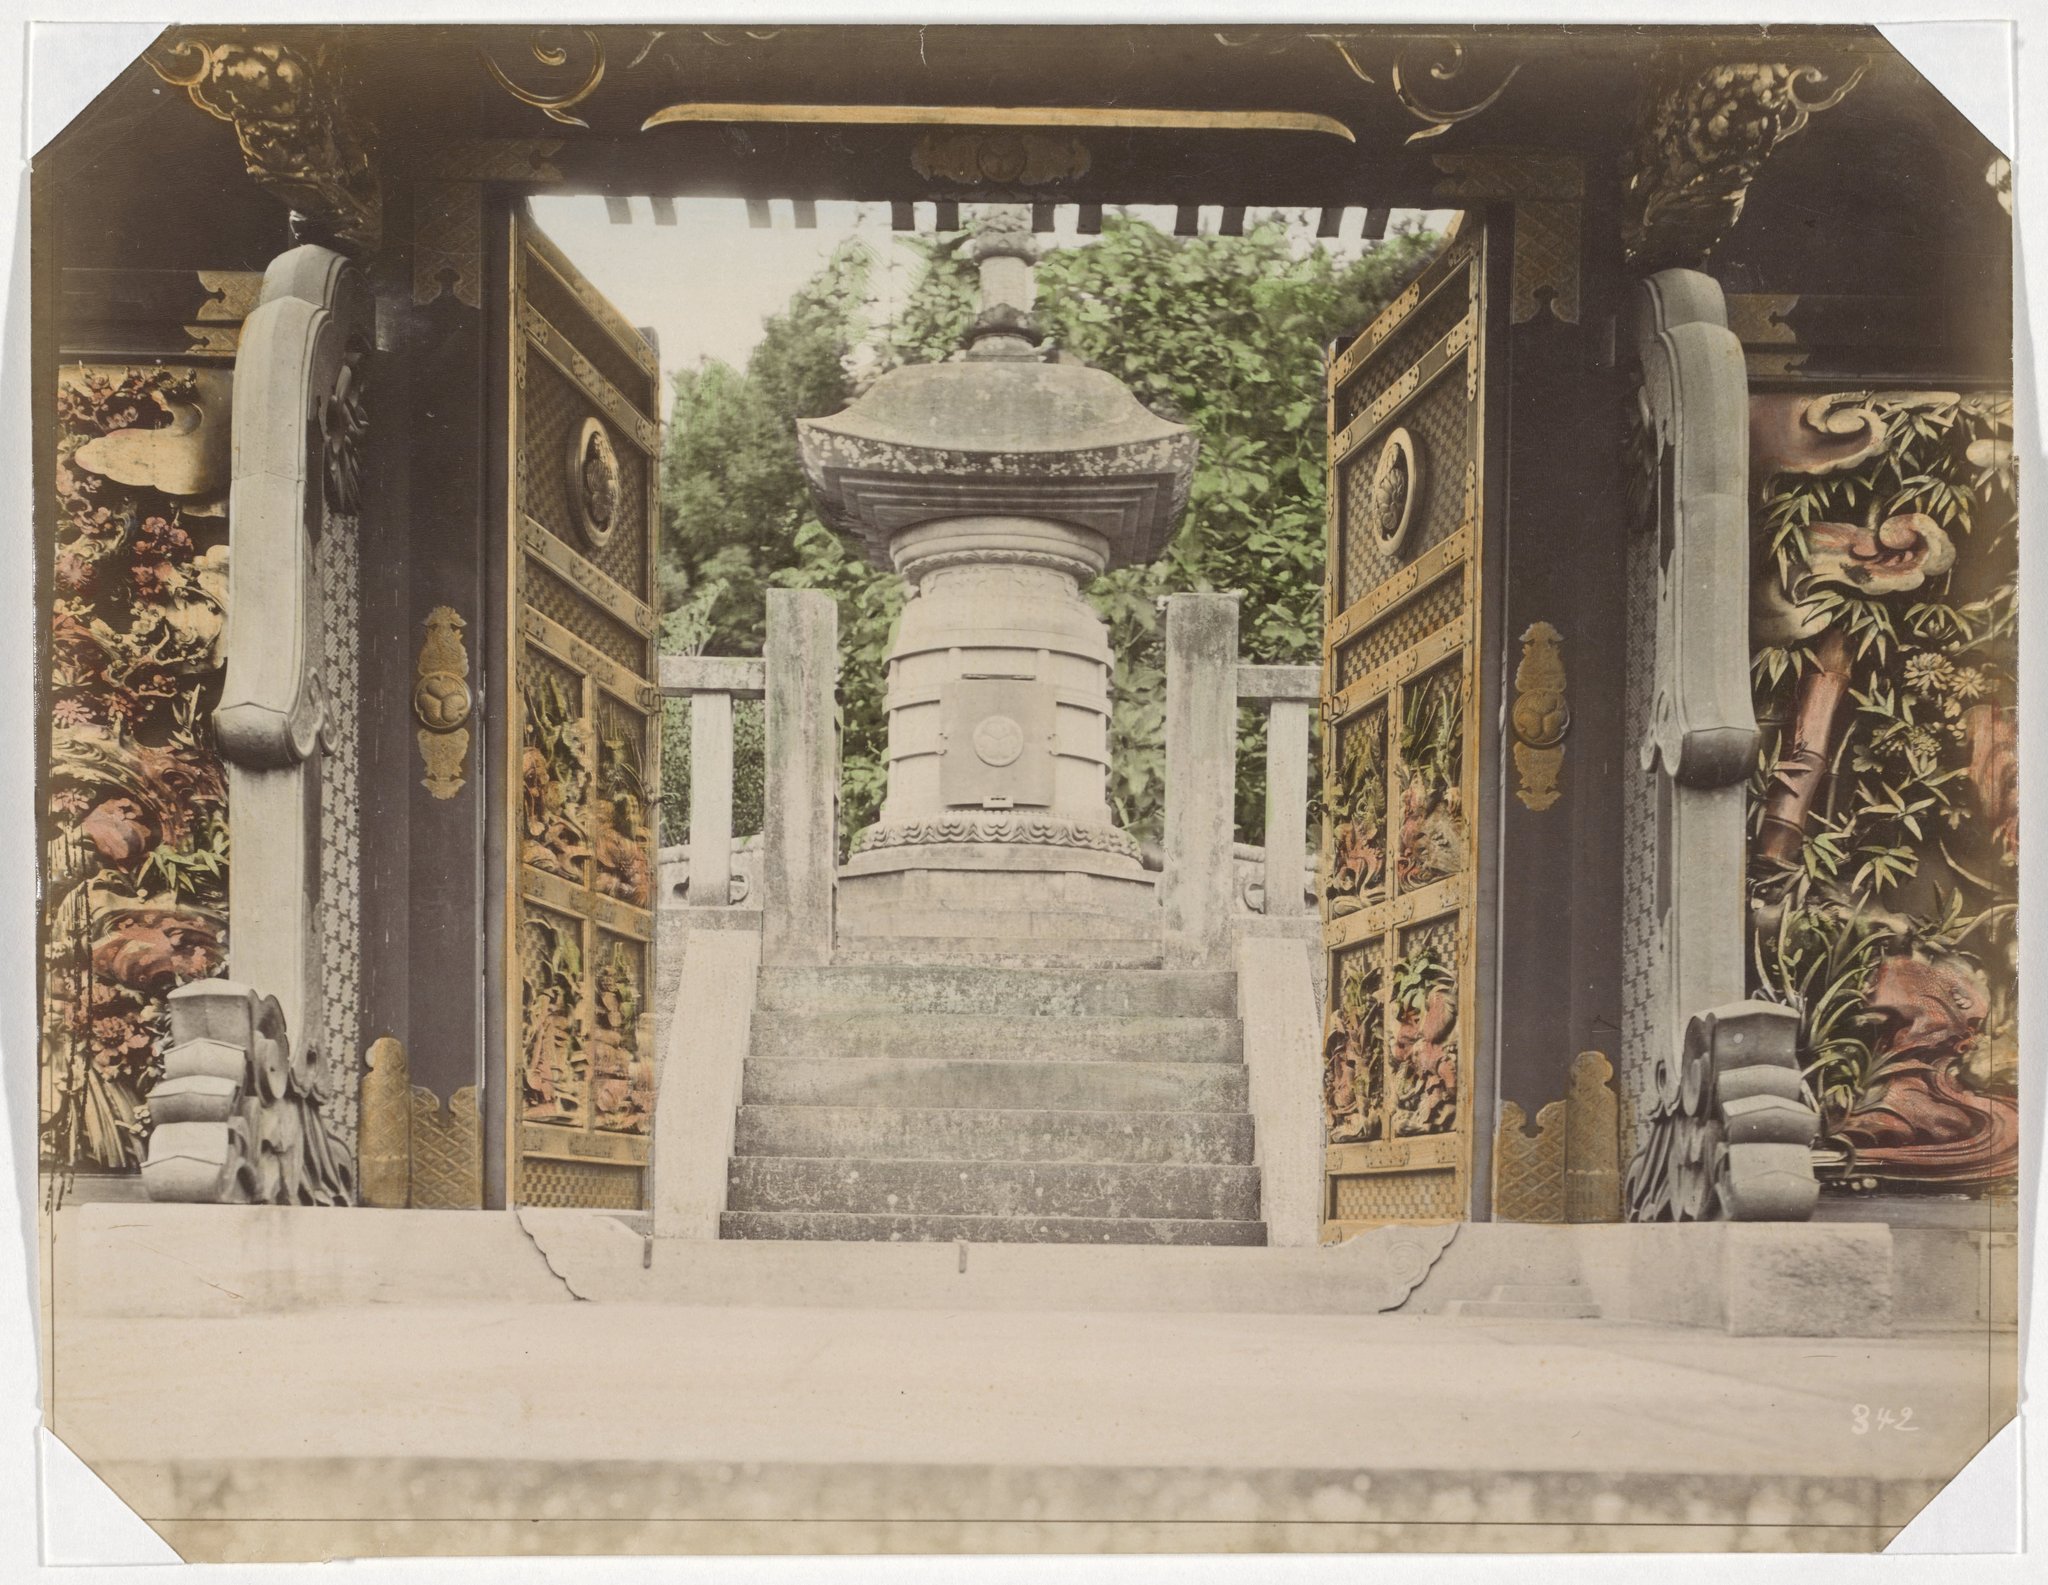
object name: photograph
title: Graf van zesde shogun in het Shiba-park in Tokyo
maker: Anonymous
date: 1890-1894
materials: cardboard, paper, photographic support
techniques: albumen print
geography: tokyo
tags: temple, shrine ~ hinduism, buddhism, jainism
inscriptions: negative number: ‘342’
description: Onderdeel van Album met 69 foto's van een reis door Japan.